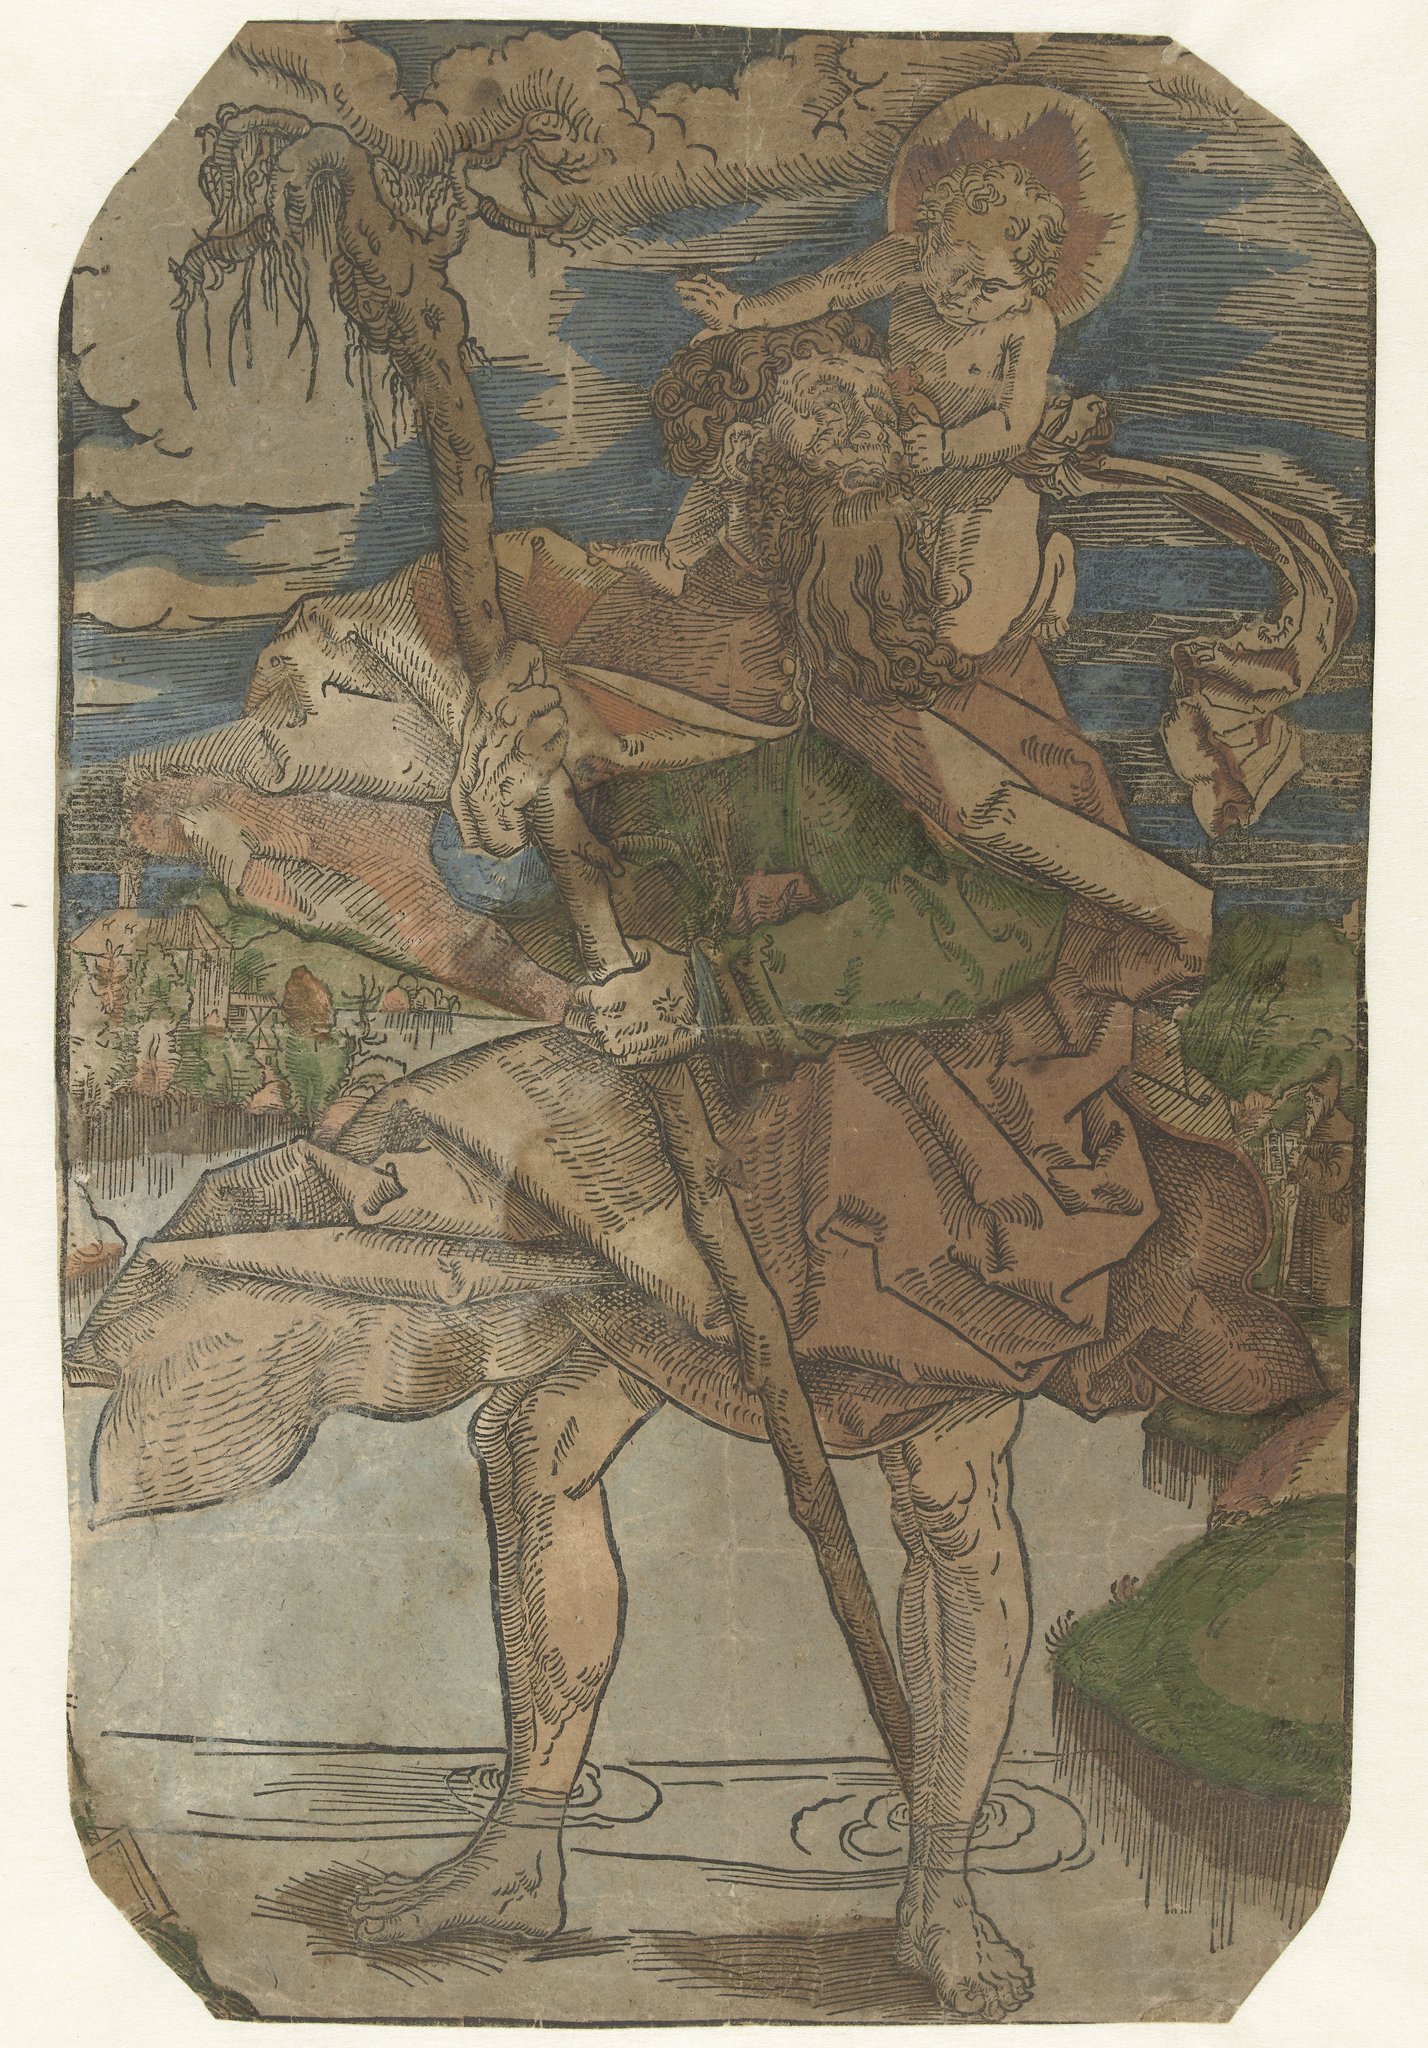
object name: print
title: Christoffel draagt het Christuskind over rivier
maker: Anonymous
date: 1511-1595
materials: paper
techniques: hand coloring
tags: st. christopher, with the infant christ on his shoulders, wading through the water and carrying his staff (palm-tree); sometimes a hermit stands on the further bank beside a chapel, a lantern in his hand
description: Christoffel of Christofoor draagt het Christuskind op zijn schouders over de rivier. Hij houdt een staf in zijn hand, gemaakt van een ontwortelde palmboom en hij staat tot zijn enkels in het water. Op de oever rechts staat de kluizenaar met een lantaarn.